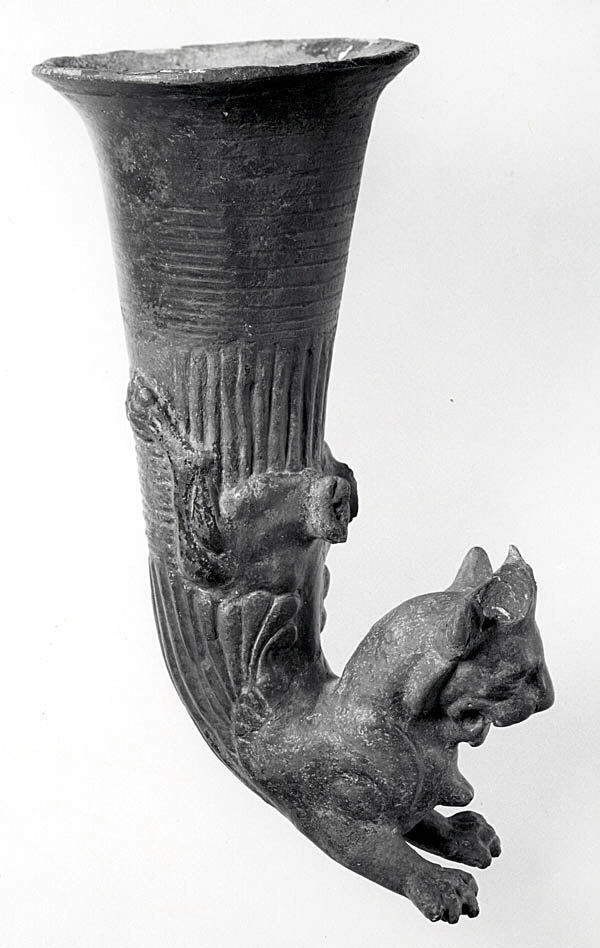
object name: rhyton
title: Rhyton terminating in a horned lion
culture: achaemenid or seleucid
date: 400-201 BCE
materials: ceramic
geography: anatolia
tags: lions